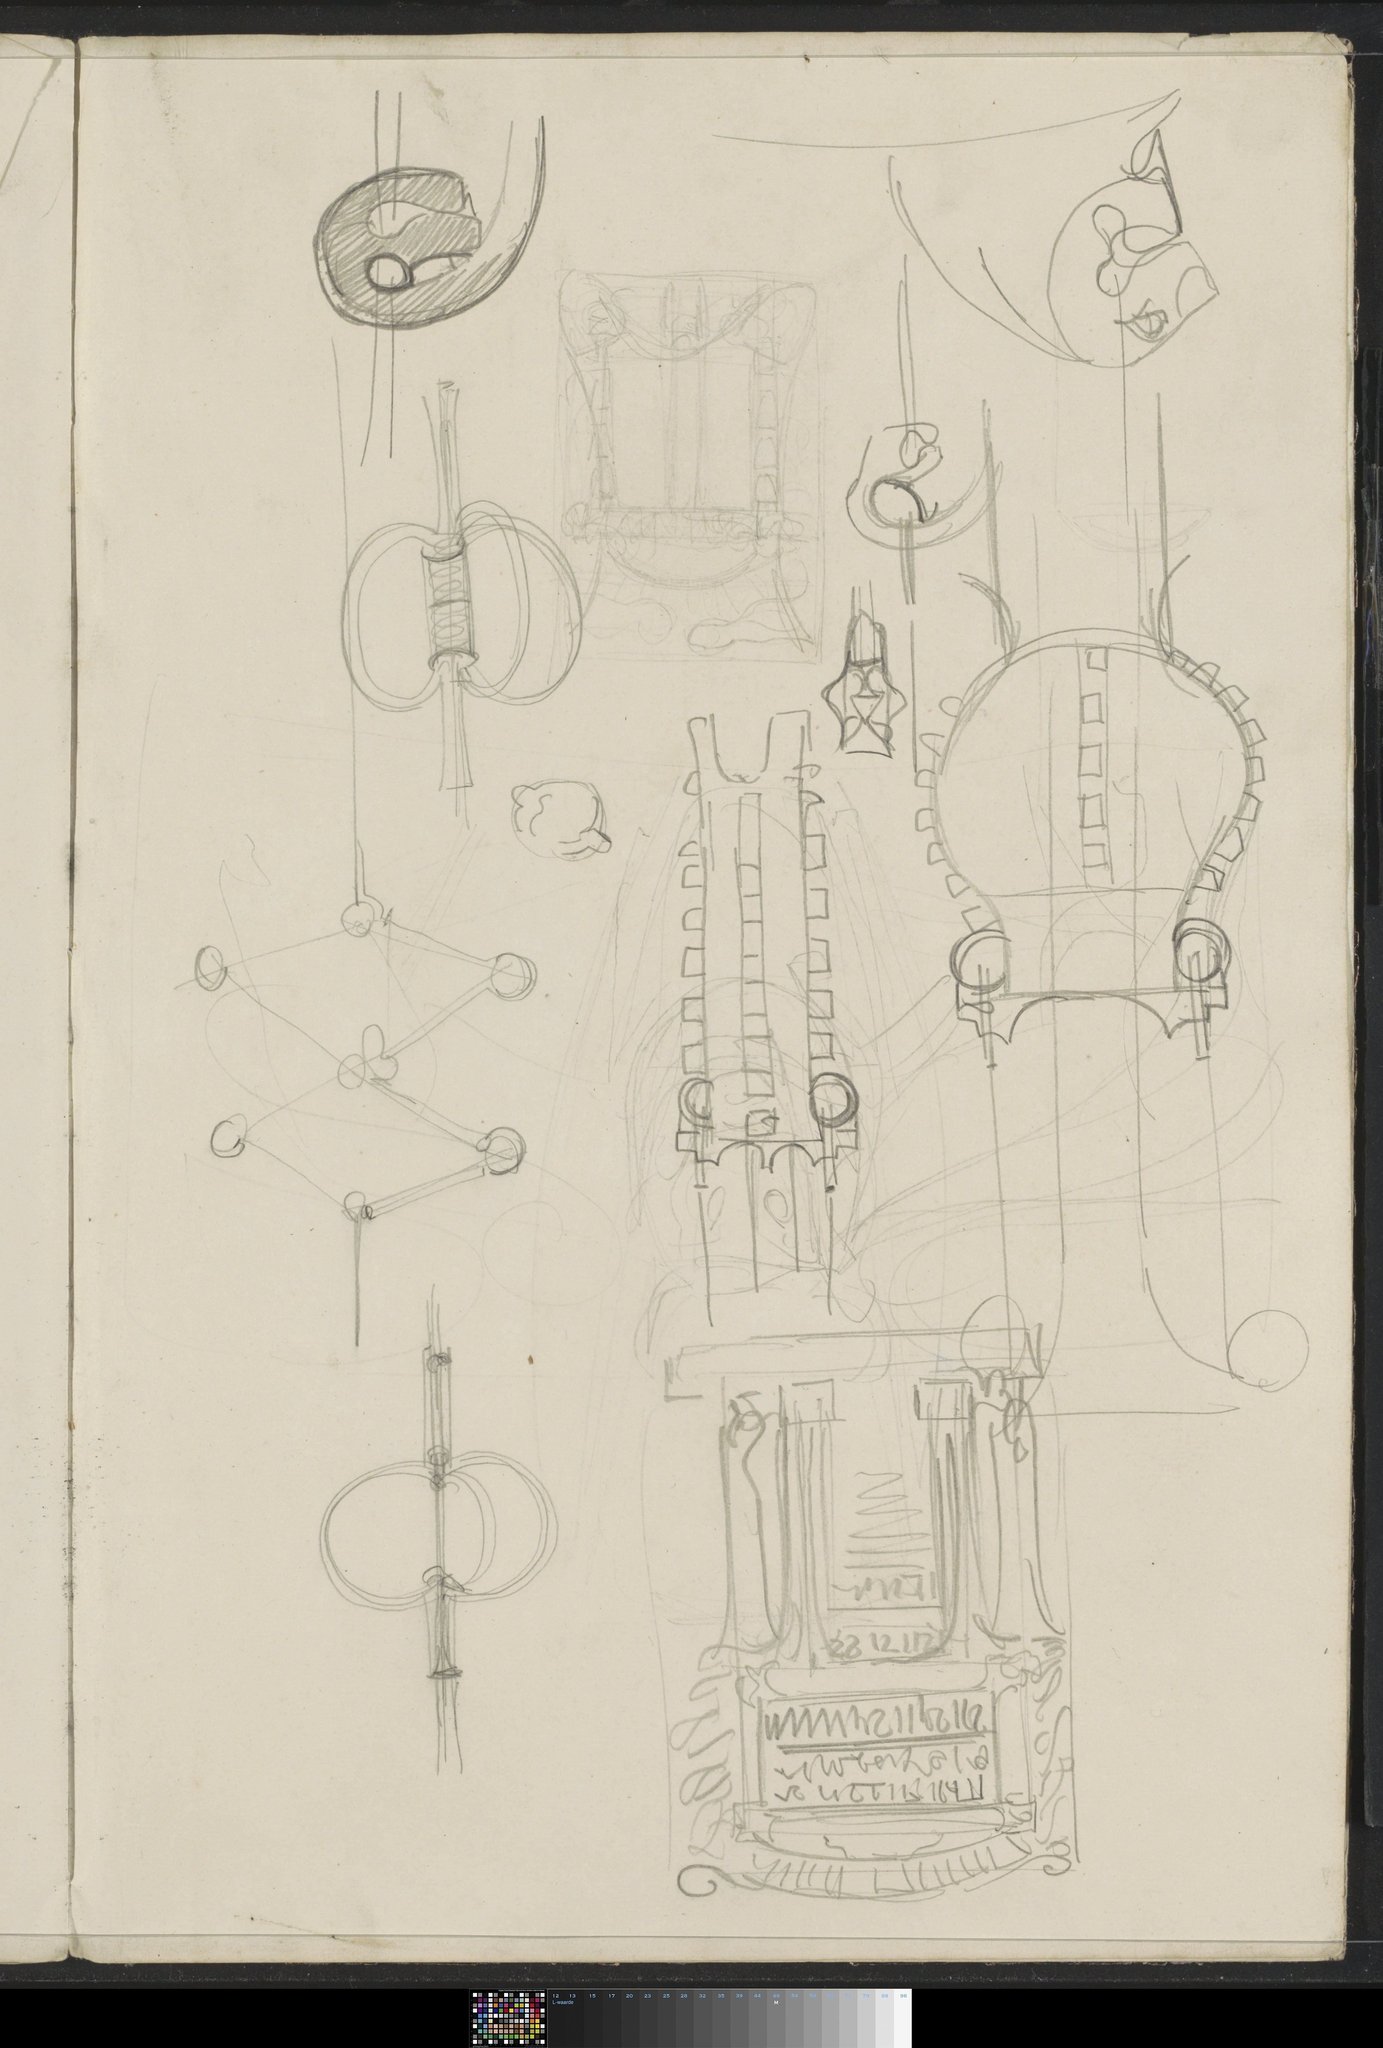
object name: sketchbook leaf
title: Ontwerpen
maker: carel adolph lion cachet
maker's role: draughtsman, print maker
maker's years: 1864-1945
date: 1903-1904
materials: paper, pencil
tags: decorative furniture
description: Vermoedelijk ontwerpen voor decoratieve objecten. Blad 17 recto uit een schetsboek met 17 bladen.